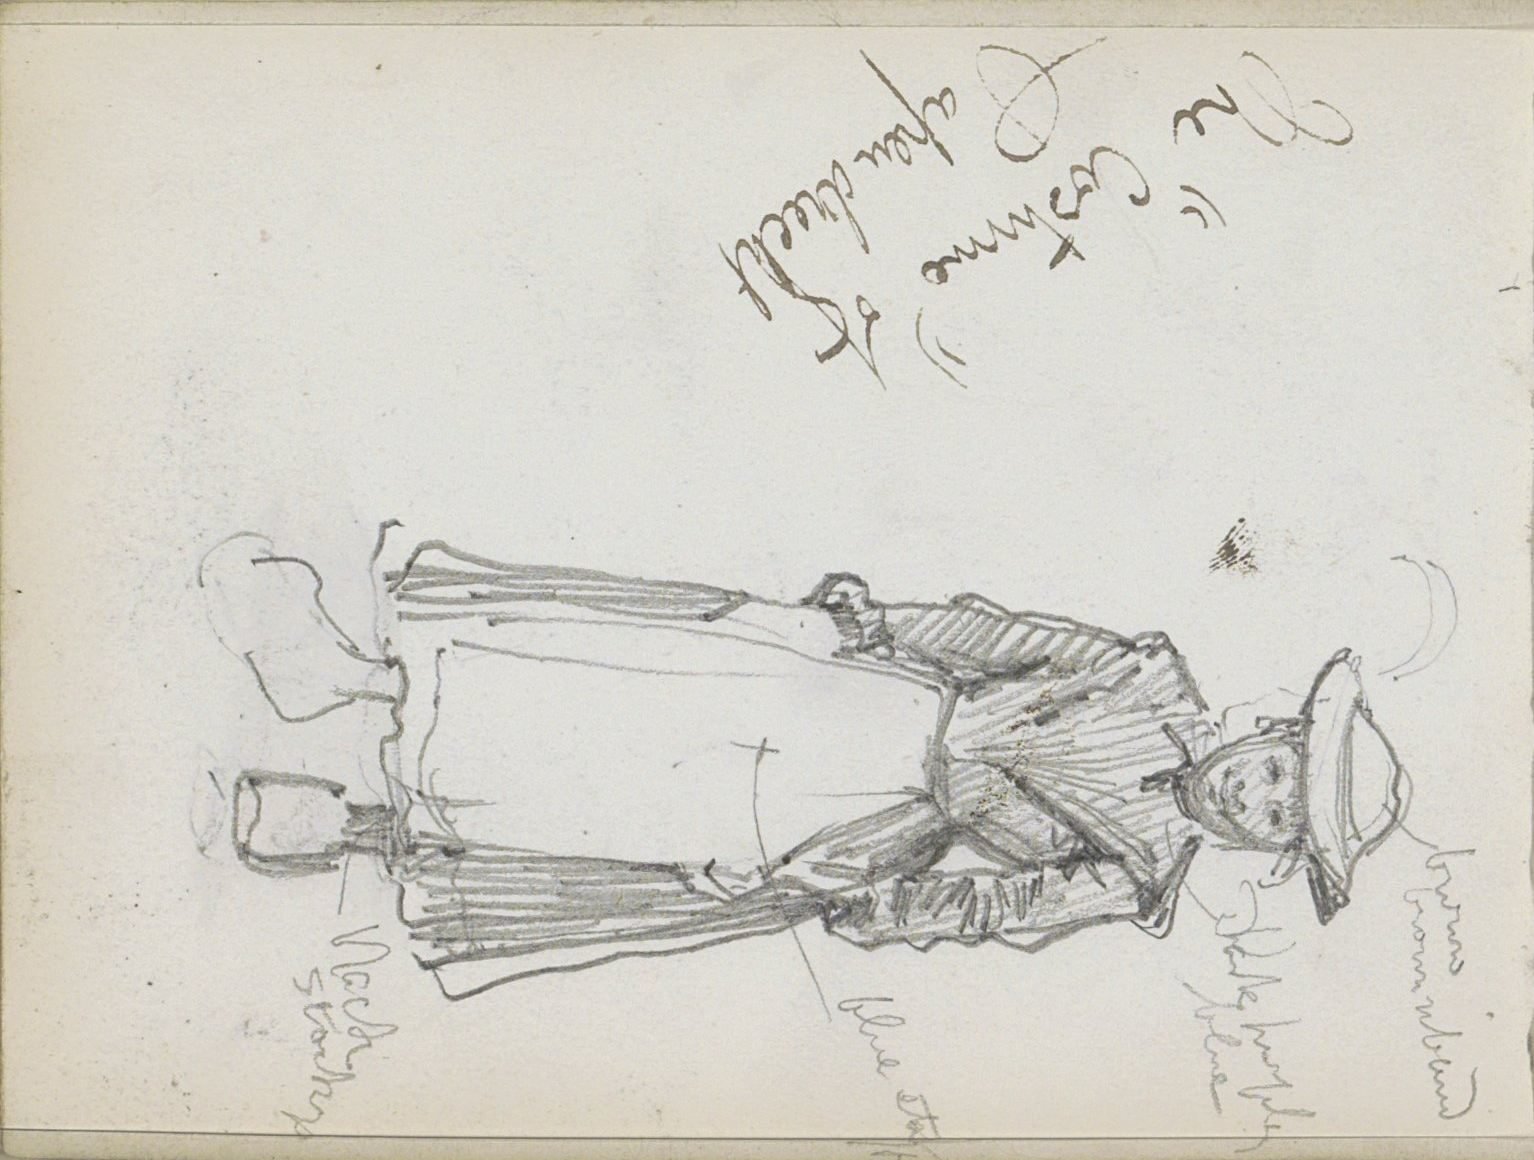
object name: sketchbook leaf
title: Staande vrouw in Papendrechtse klederdracht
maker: george clausen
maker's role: draughtsman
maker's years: 1852-1912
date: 1874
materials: paper, pencil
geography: papendrecht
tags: standing figure, adult woman, folk costume, regional costume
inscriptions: annotation: ‘The "costume" of/ Papendrecht’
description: Blad 23 verso uit een schetsboek met 37 bladen.